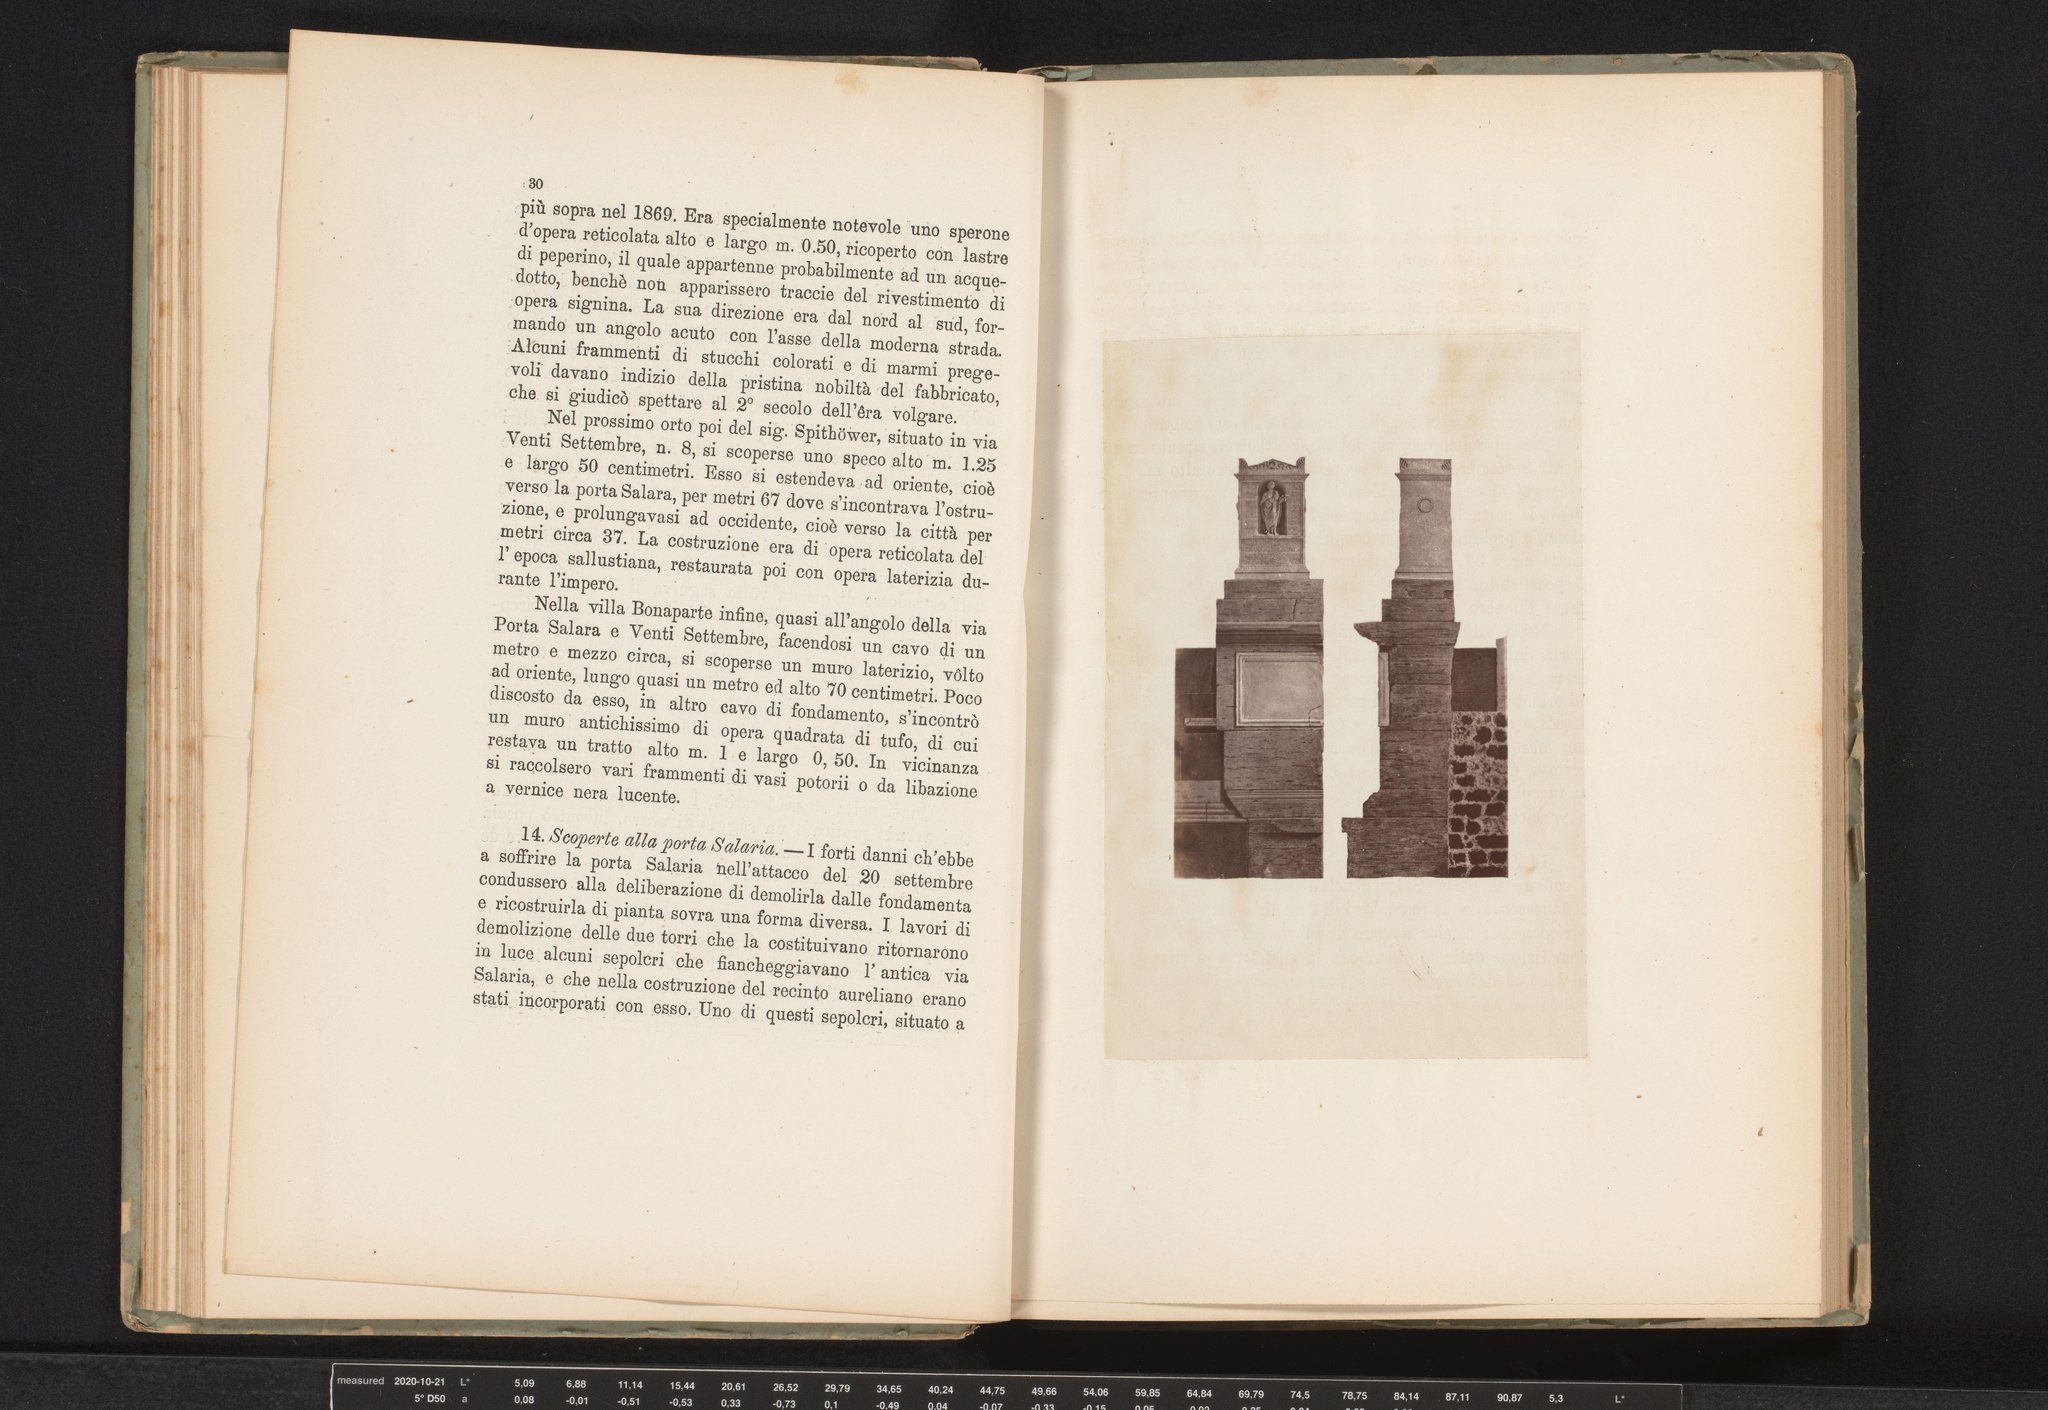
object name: photograph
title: Fotoreproductie van een schilderij, voorstellende twee aanzichten van het monument voor Quintus Sulpicius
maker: Anonymous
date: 1863-1873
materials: photographic support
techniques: albumen print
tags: monument, statue